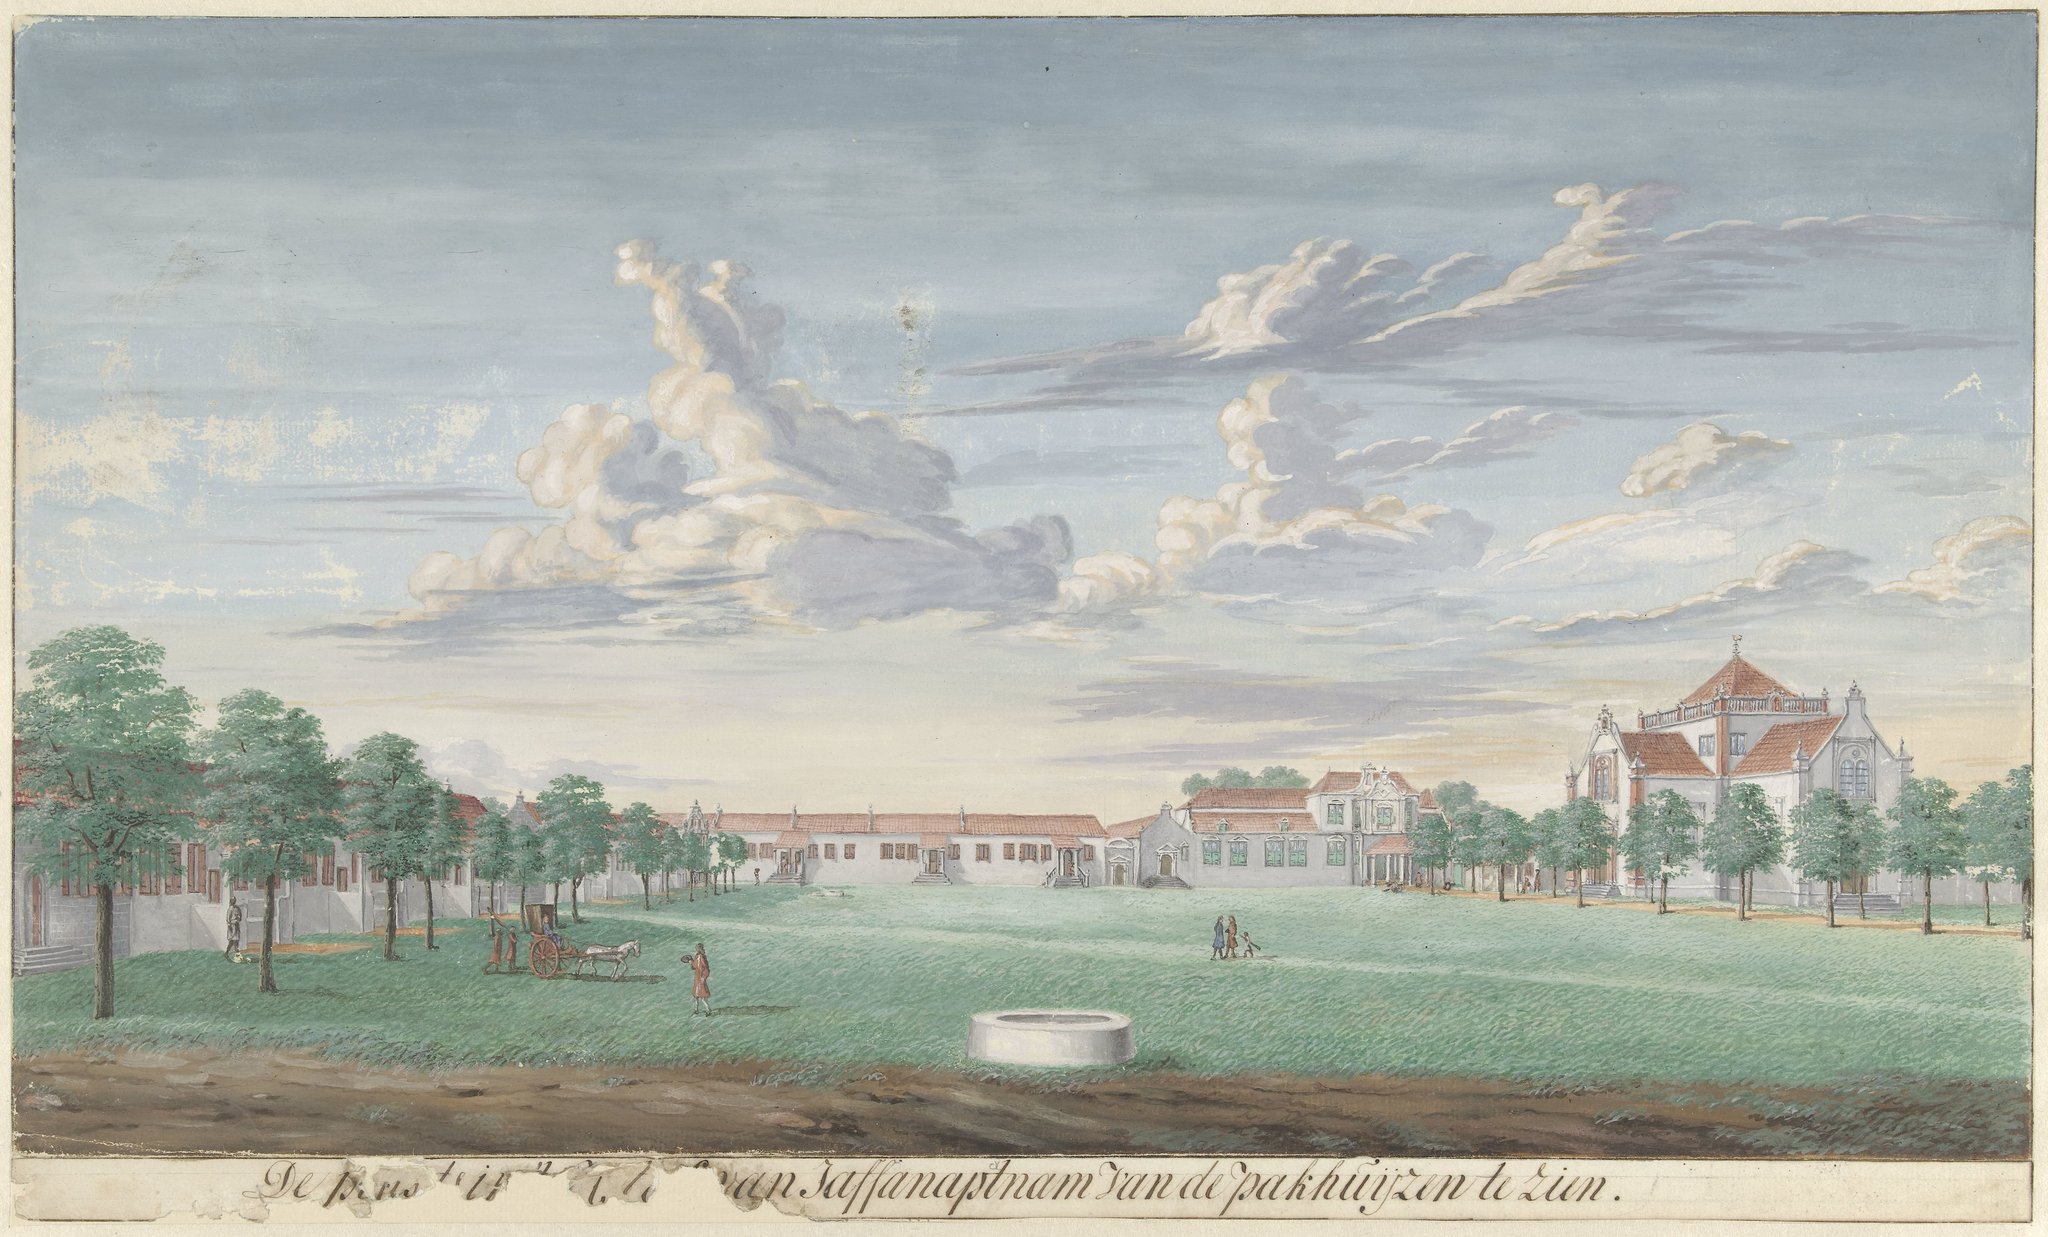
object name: drawing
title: The Courtyard of Fort Jaffnapatnam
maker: cornelis steiger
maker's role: draughtsman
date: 1710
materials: paint, paper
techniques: brush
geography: sri lanka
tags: fortress, church (exterior), sri lanka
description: The forts captured from the Portuguese were taken over and fortified by the VOC. These forts constituted a crucial chain that extended along the entire coast of the island. While their primary purpose was to deter European competitors, they were also used to restrict the king of Kandy’s freedom of movement.